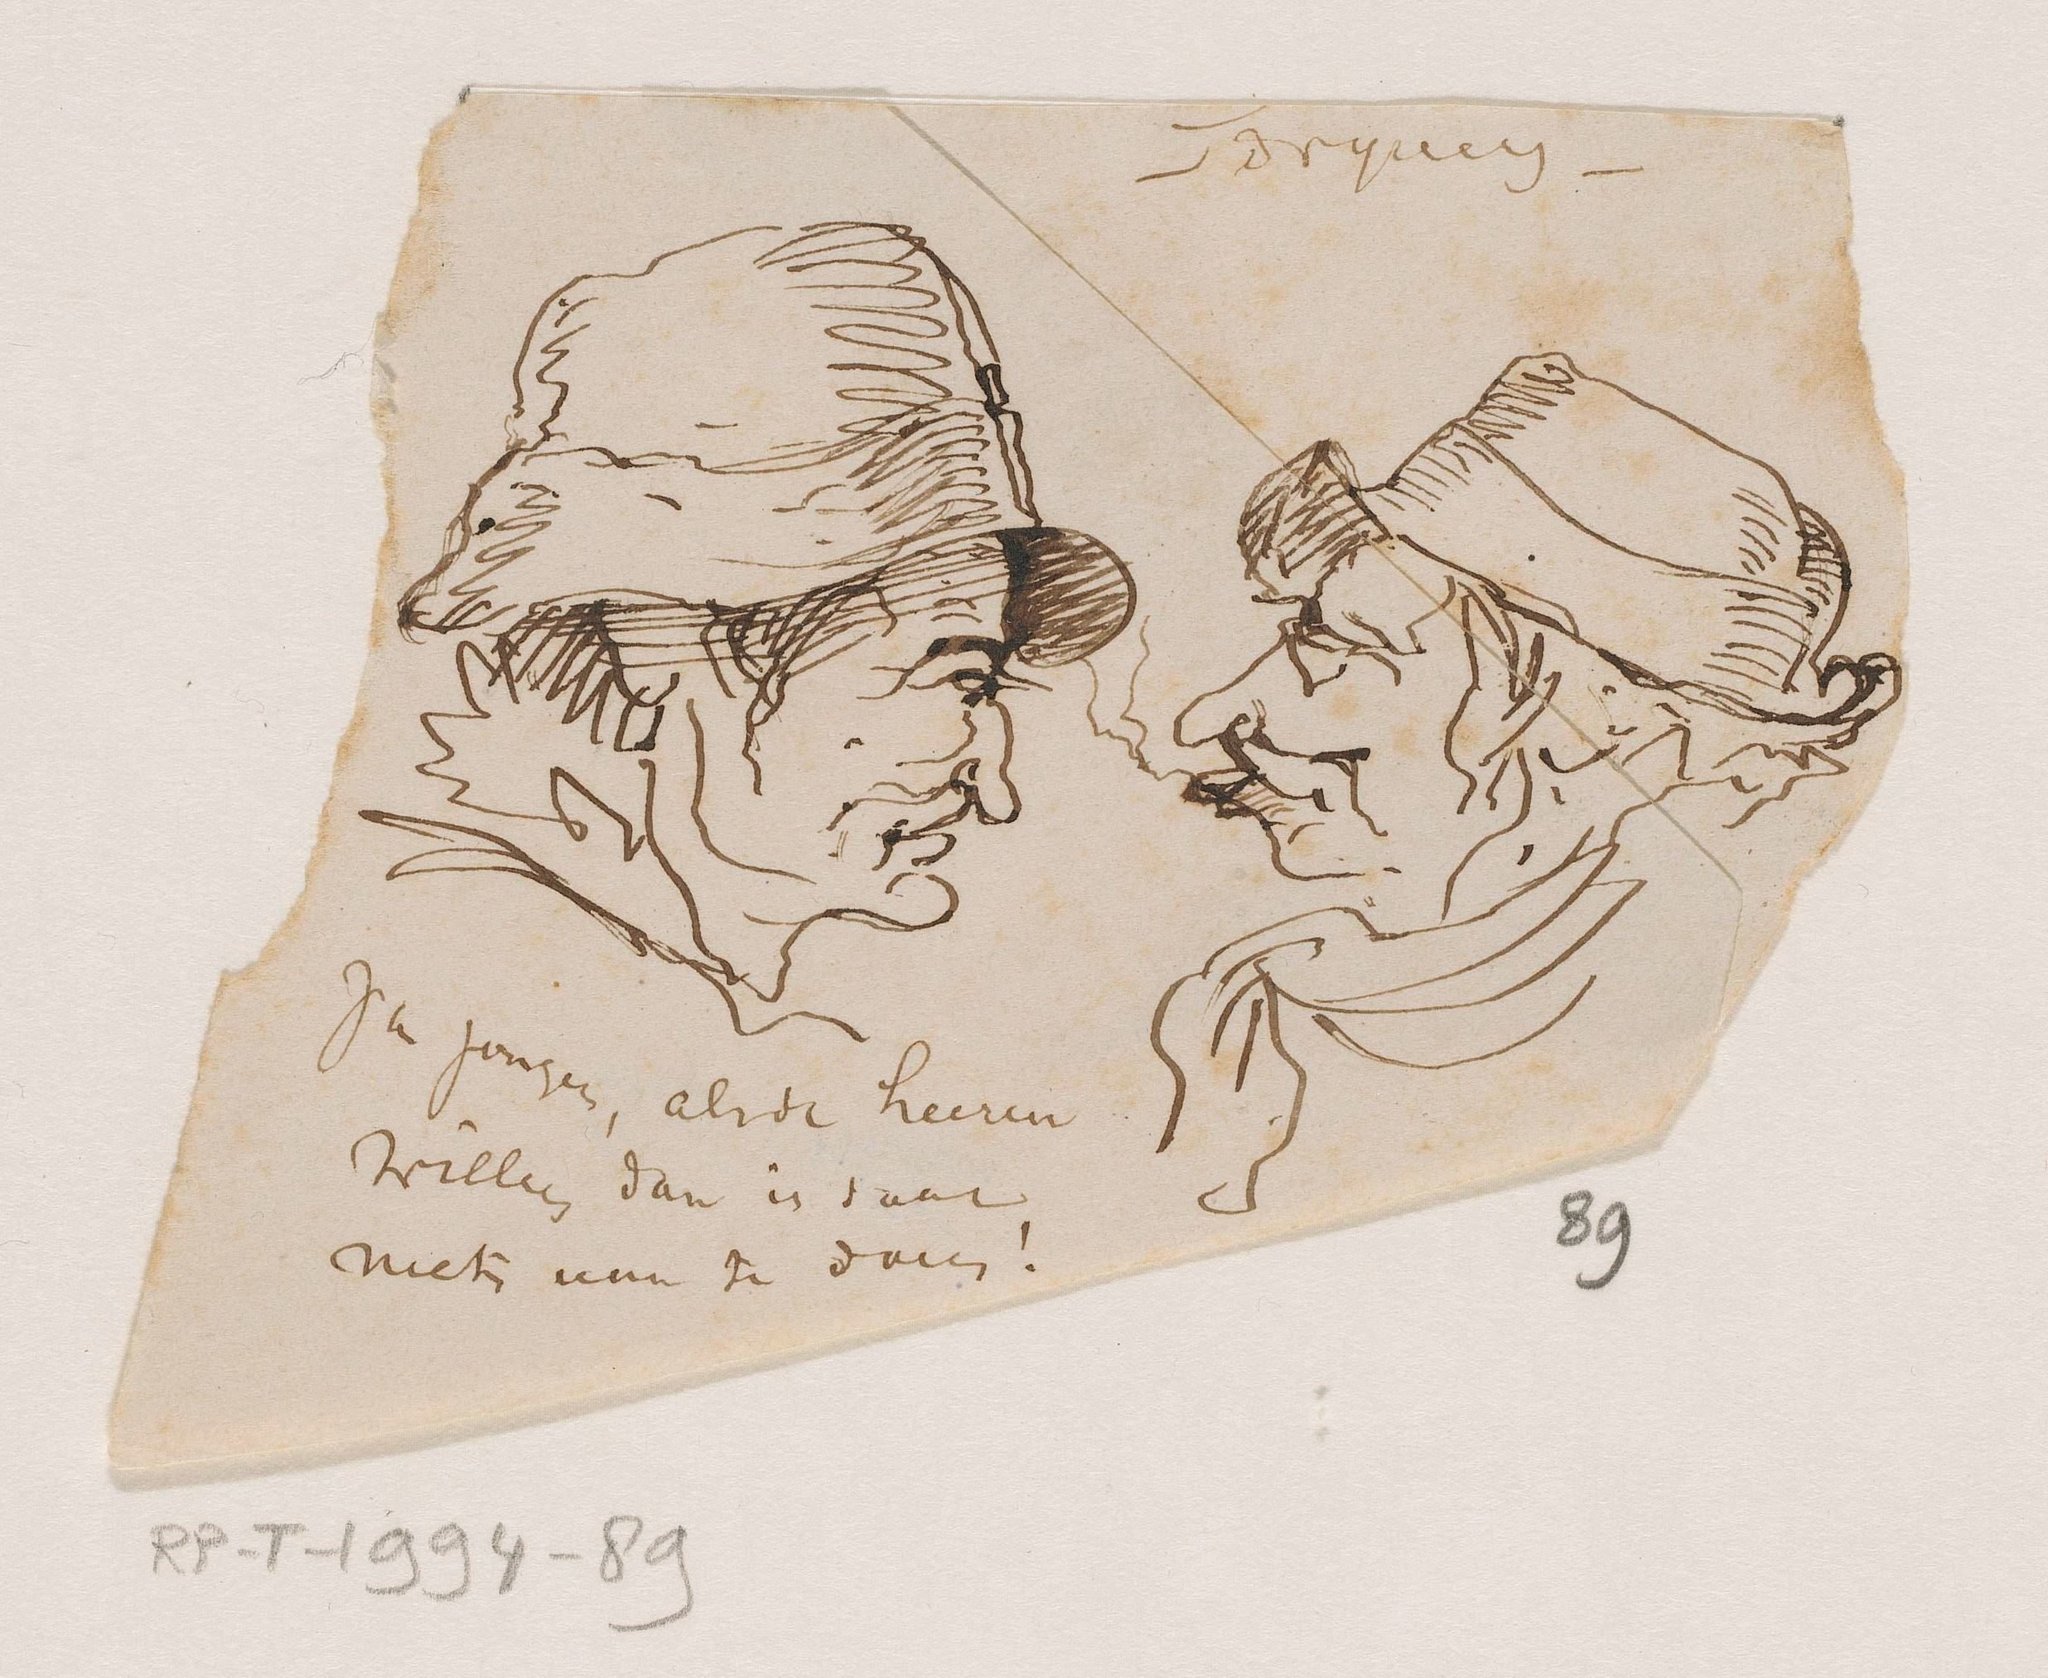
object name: drawing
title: Twee karikaturale manskoppen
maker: johannes tavenraat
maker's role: draughtsman, painter, print maker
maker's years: 1809-1881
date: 1819-1881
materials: ink, paper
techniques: pen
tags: caricatures (human types)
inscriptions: inscription: ‘Ja jongen, als de heeren / willen dan is daar / niets aan te doen!’